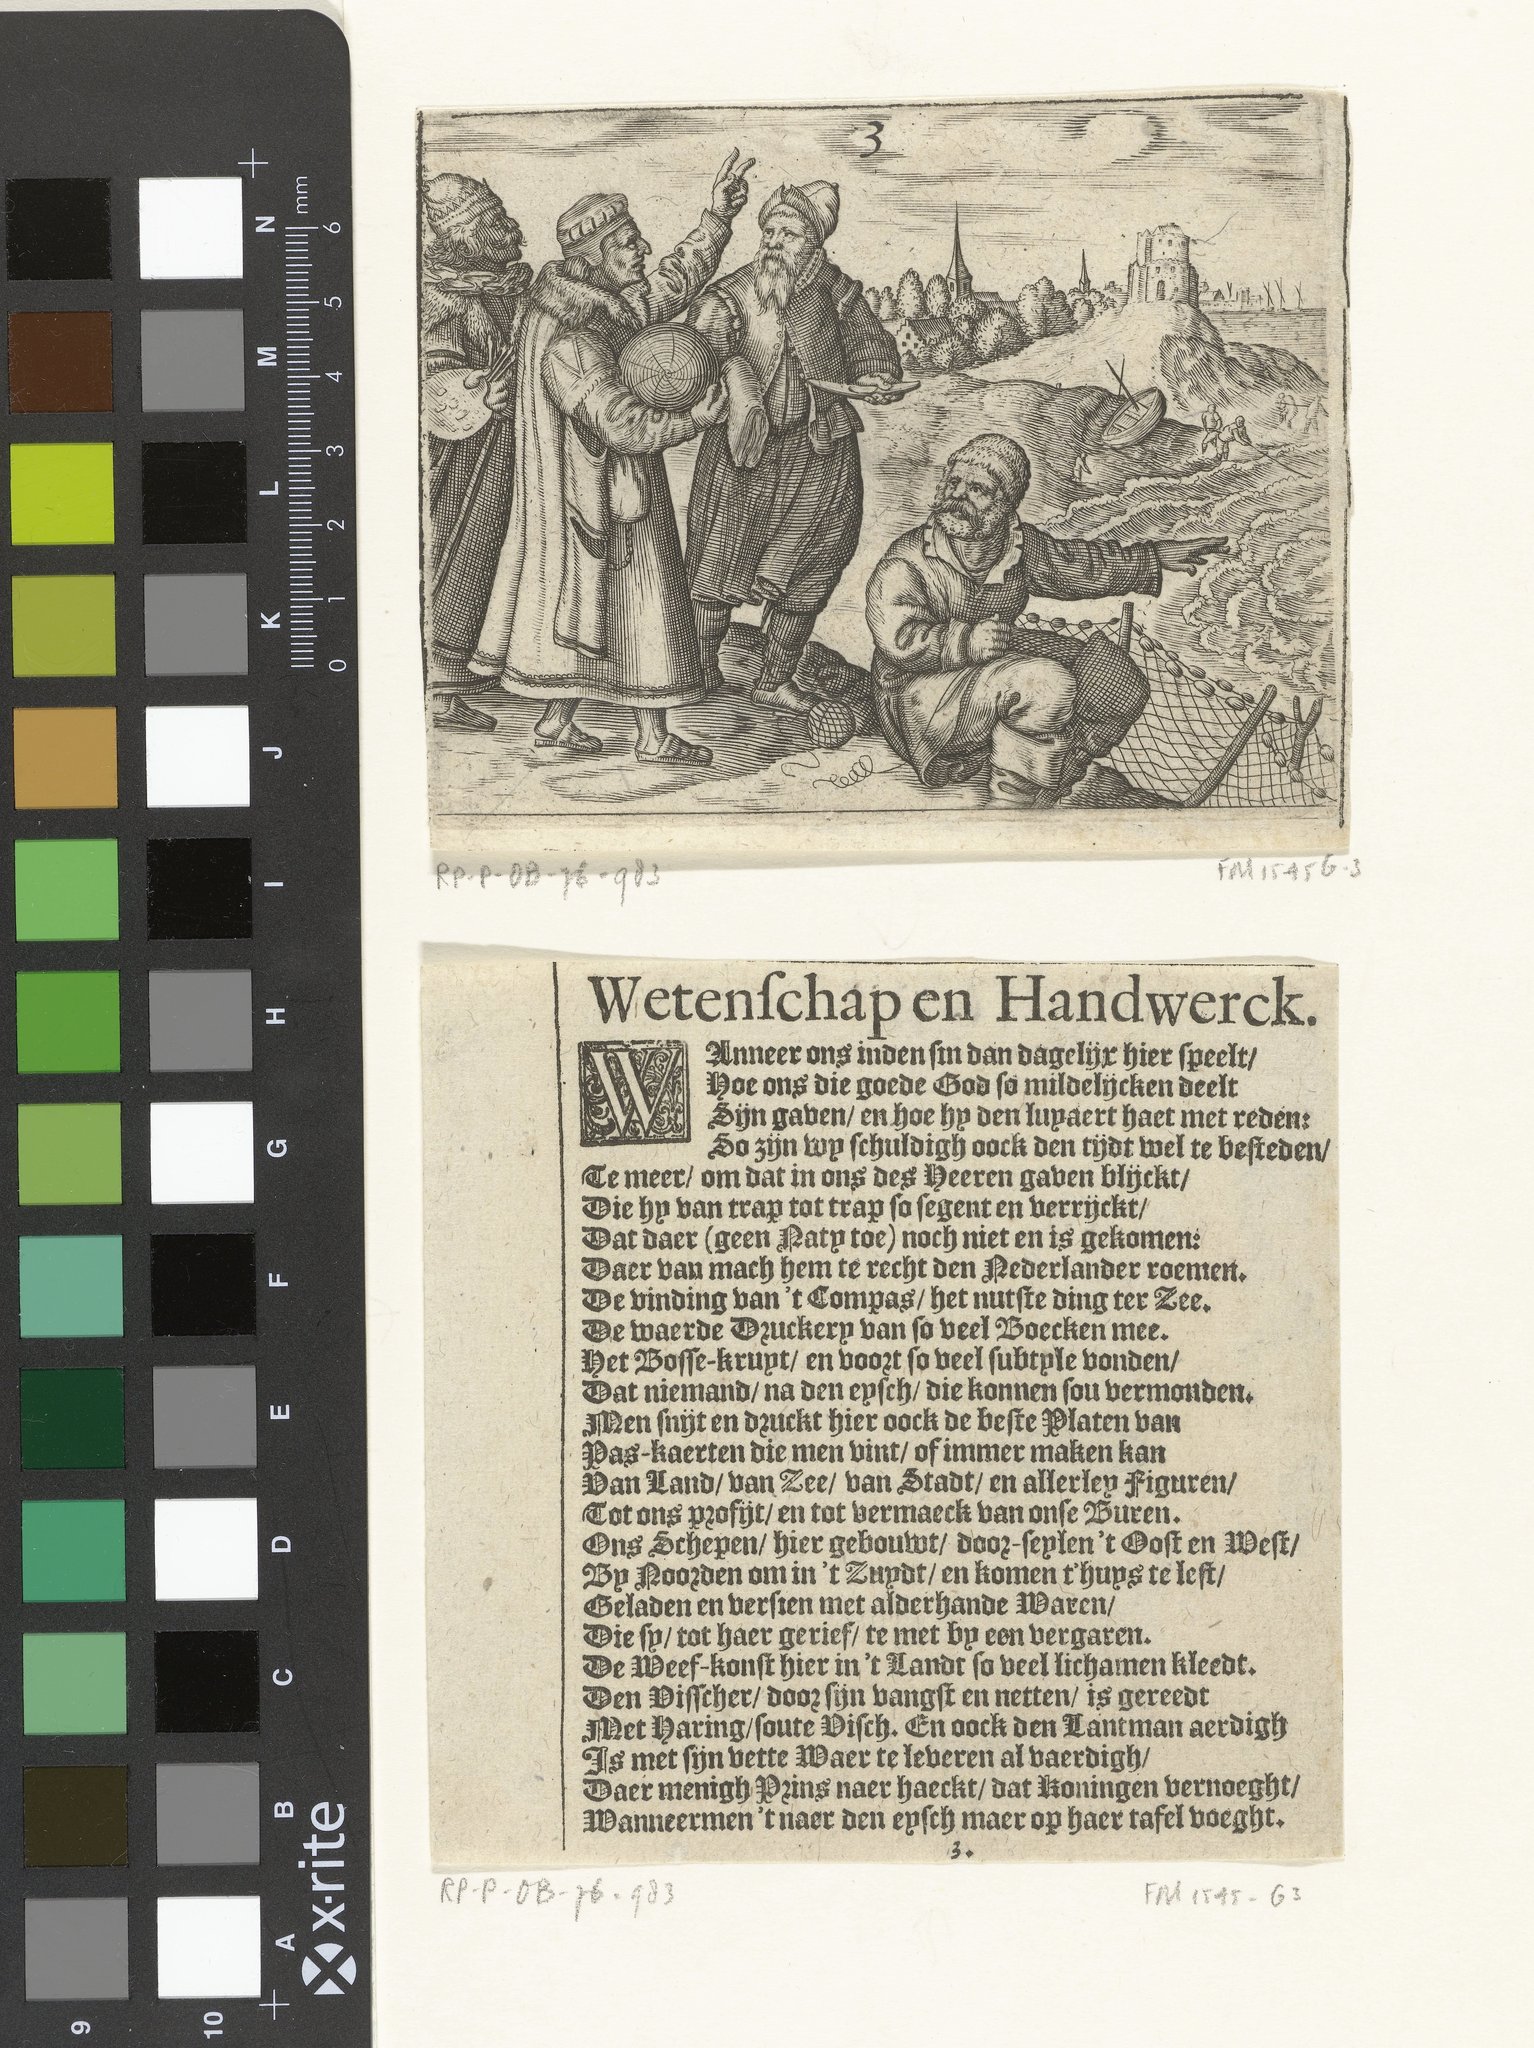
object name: print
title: Voorstellingen uit de Nederlandse maatschappij, ca. 1625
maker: Anonymous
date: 1620-1629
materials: paper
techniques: engraving, letterpress printing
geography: northern netherlands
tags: aspects of science in general, fisherman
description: Wetenschap en Handwerk. In een landschap op de voorgrond links drie geleerden, rechts een visser bij zijn net. Heuvels op de achtergrond. Onderdeel van een serie voorstellingen van de Nederlandse maatschappij, ca. 1625. De prent met het bijbehorende vers op een apart blad.